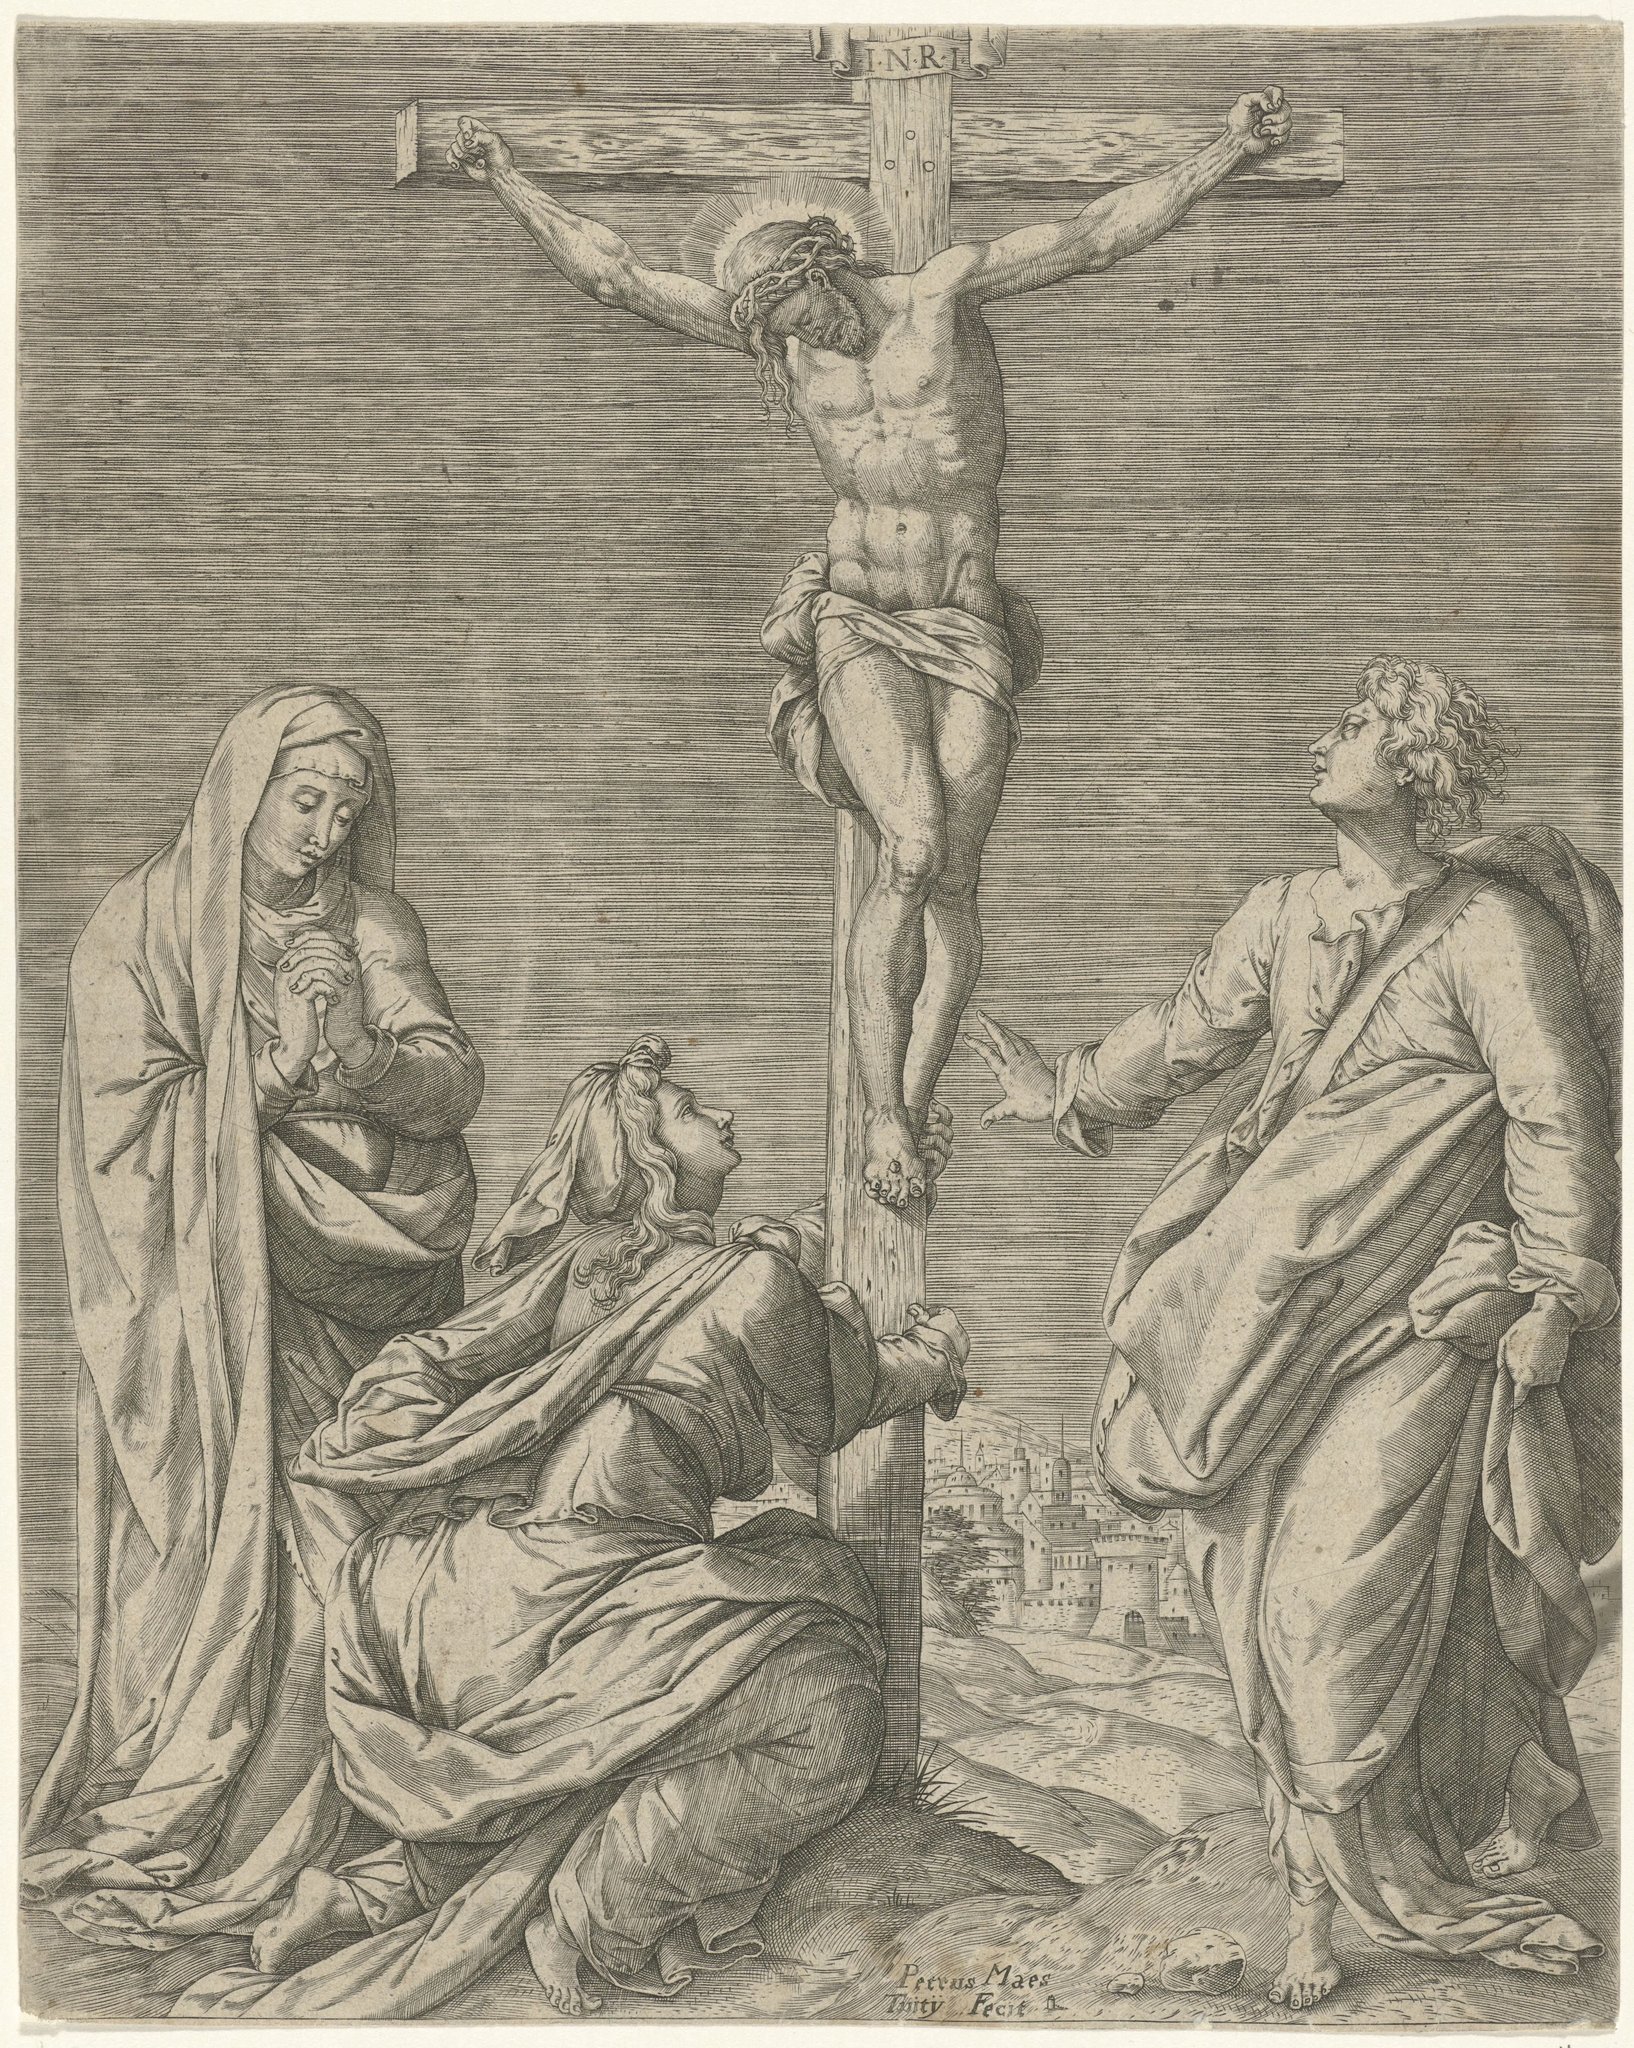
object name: print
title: Kruisiging van Christus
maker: pieter maes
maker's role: print maker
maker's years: 1560-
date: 1577-1591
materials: paper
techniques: engraving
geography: low countries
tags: crucified christ with mary, john, and mary magdalene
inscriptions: collector's mark: Lugt 514, collector's mark: Lugt 2228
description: Christus aan het kruis. Links knielt Maria Magdalena met beide handen het kruis omvattend en links van haar staat Maria met haar handen ineen geslagen. Rechts Johannes.